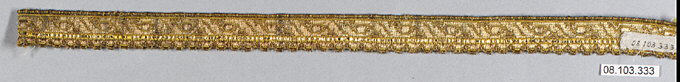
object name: galloon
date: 1801-1900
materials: metal thread